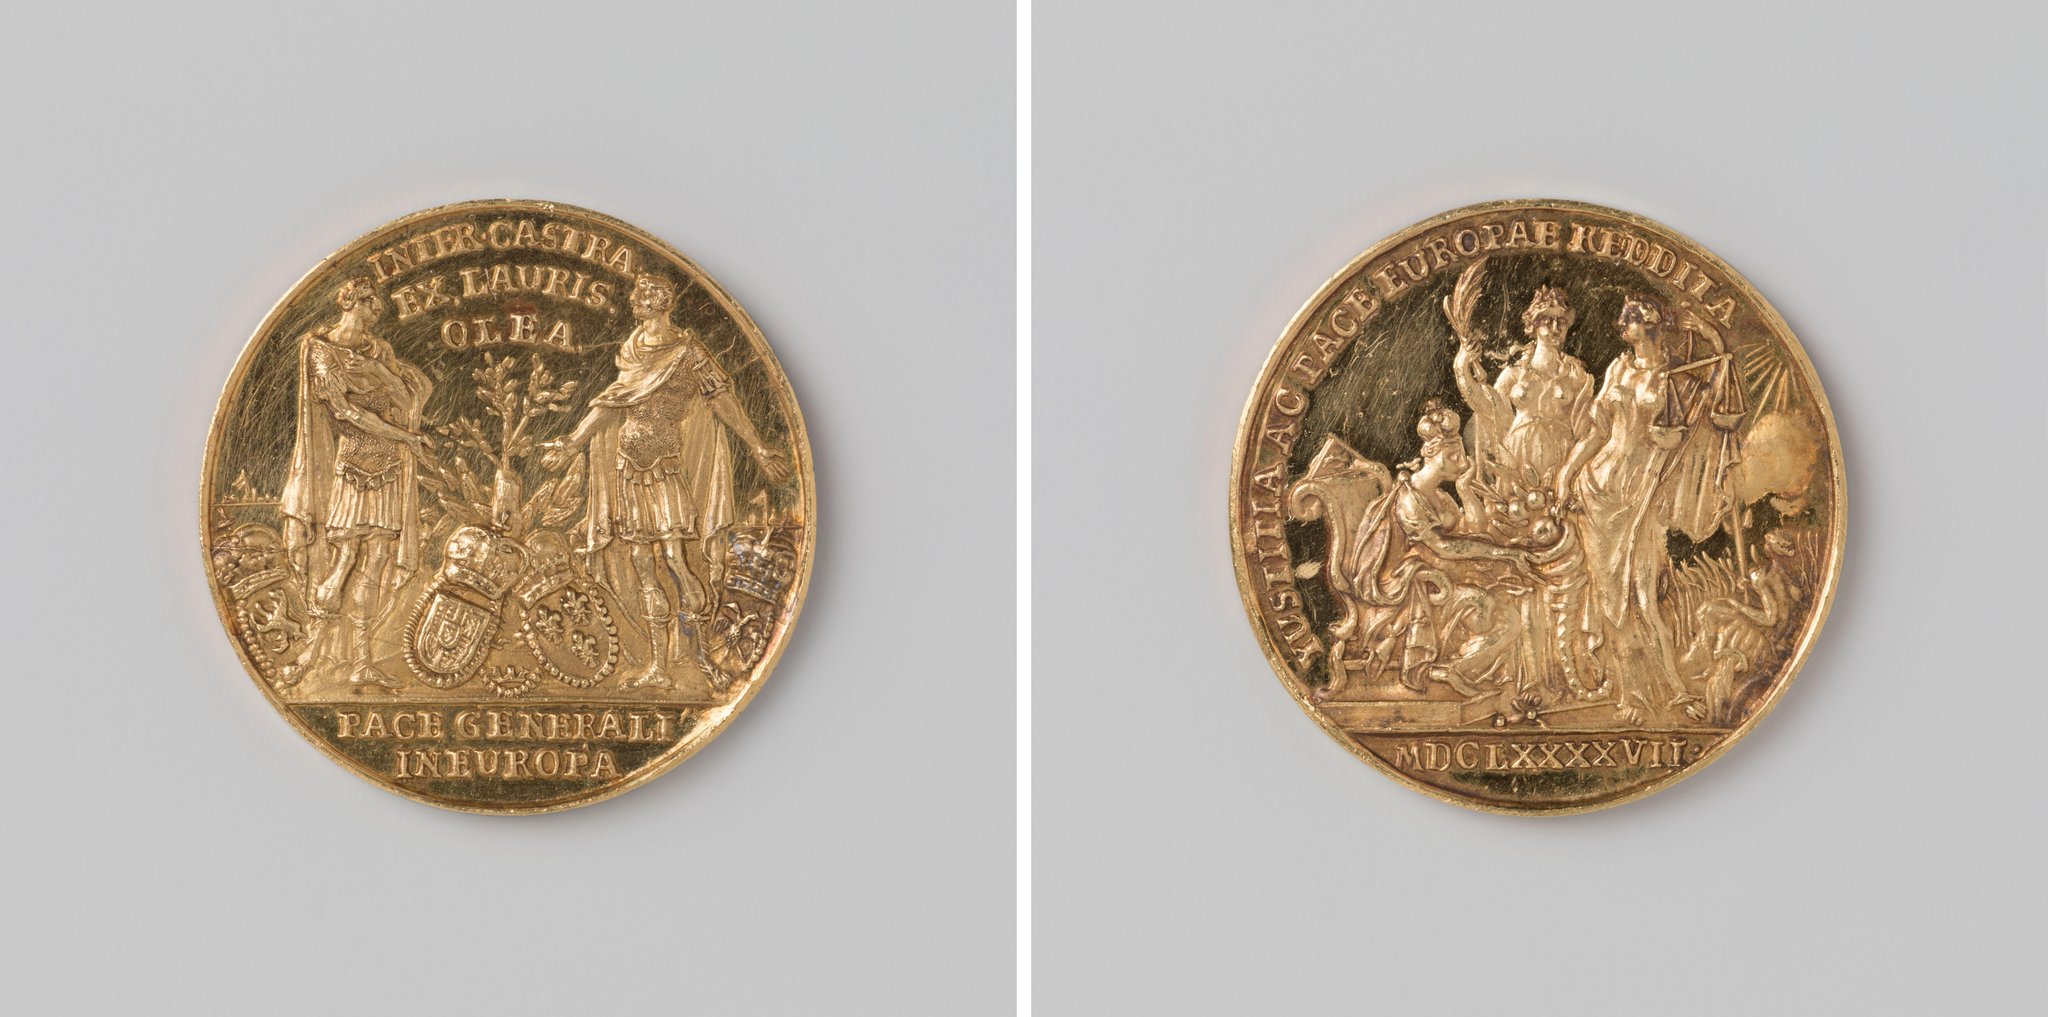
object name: strooipenning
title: Vredesonderhandelingen te Halle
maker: Anonymous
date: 1697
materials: gold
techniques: striking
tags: halle